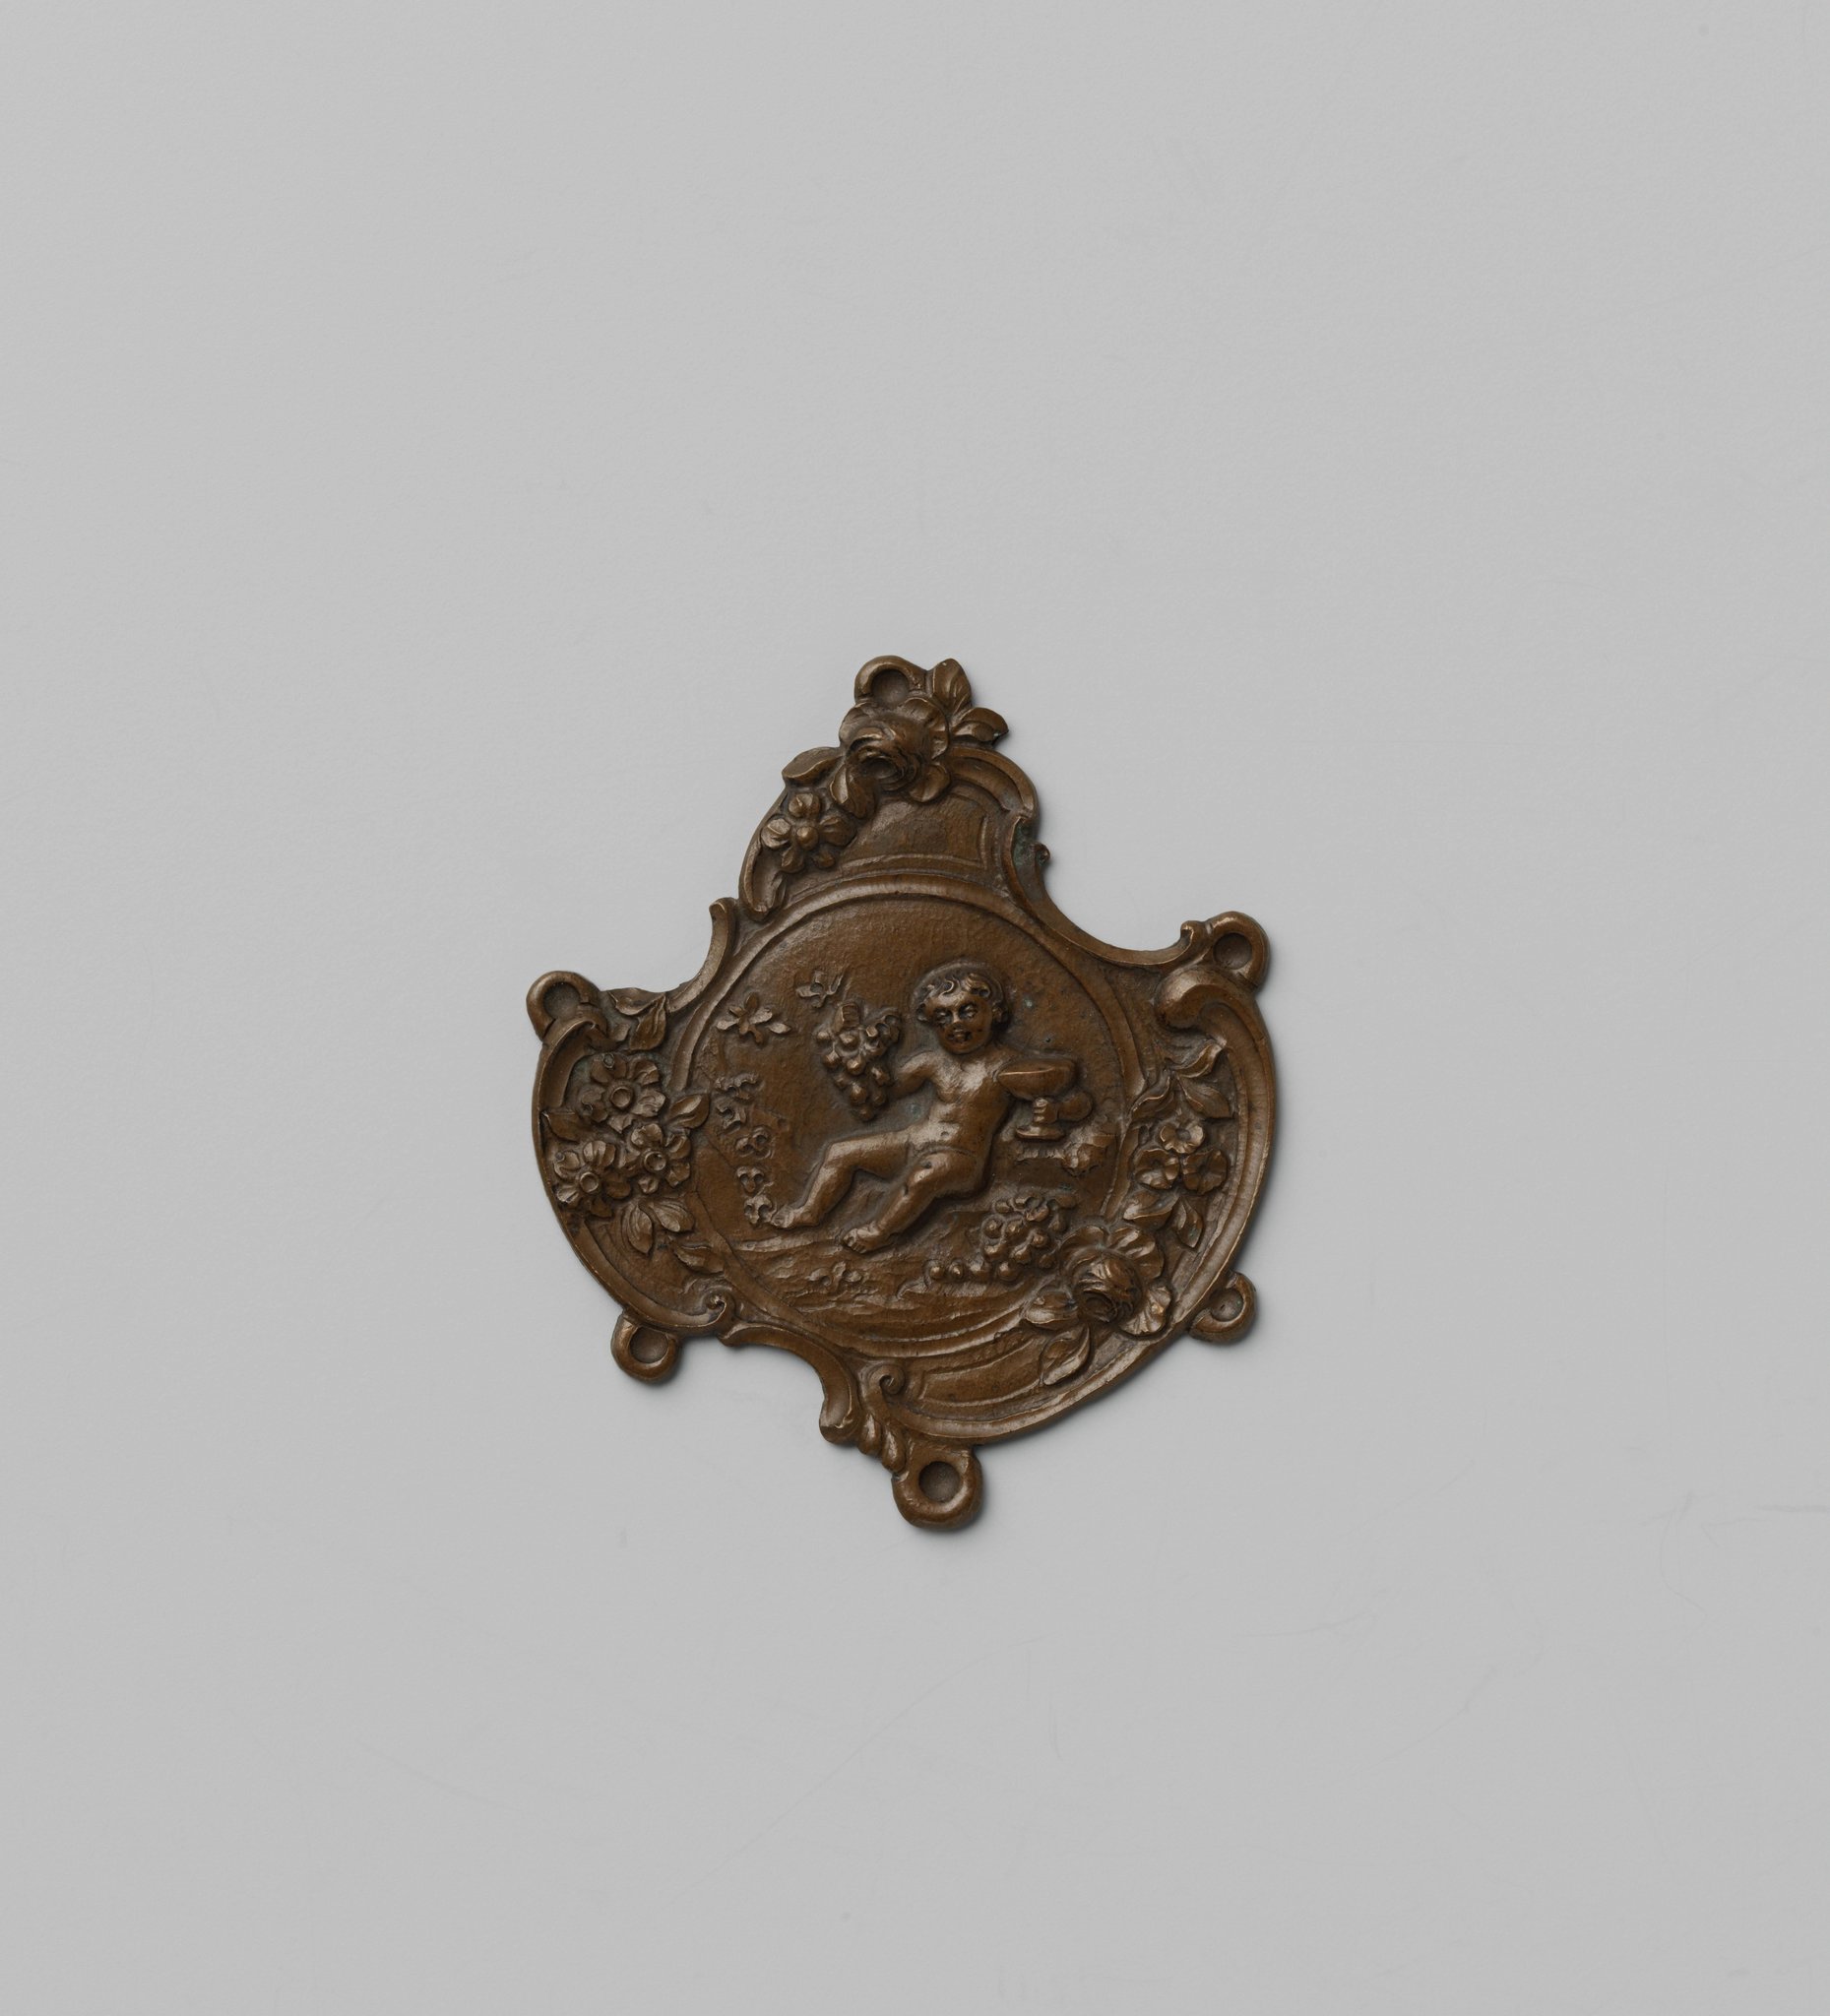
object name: model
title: Model voor een versieringselement van een chatelaine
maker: Anonymous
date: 1750-1775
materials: copper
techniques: repoussé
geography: amsterdam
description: Het uit plaat gedreven model voor een gietvorm is voorzien van een door rococo-ornament en bloemen omgeven medaillon met een putto met druiventros en kelk. Langs de randen zes ogen ter bevestiging van schakels.